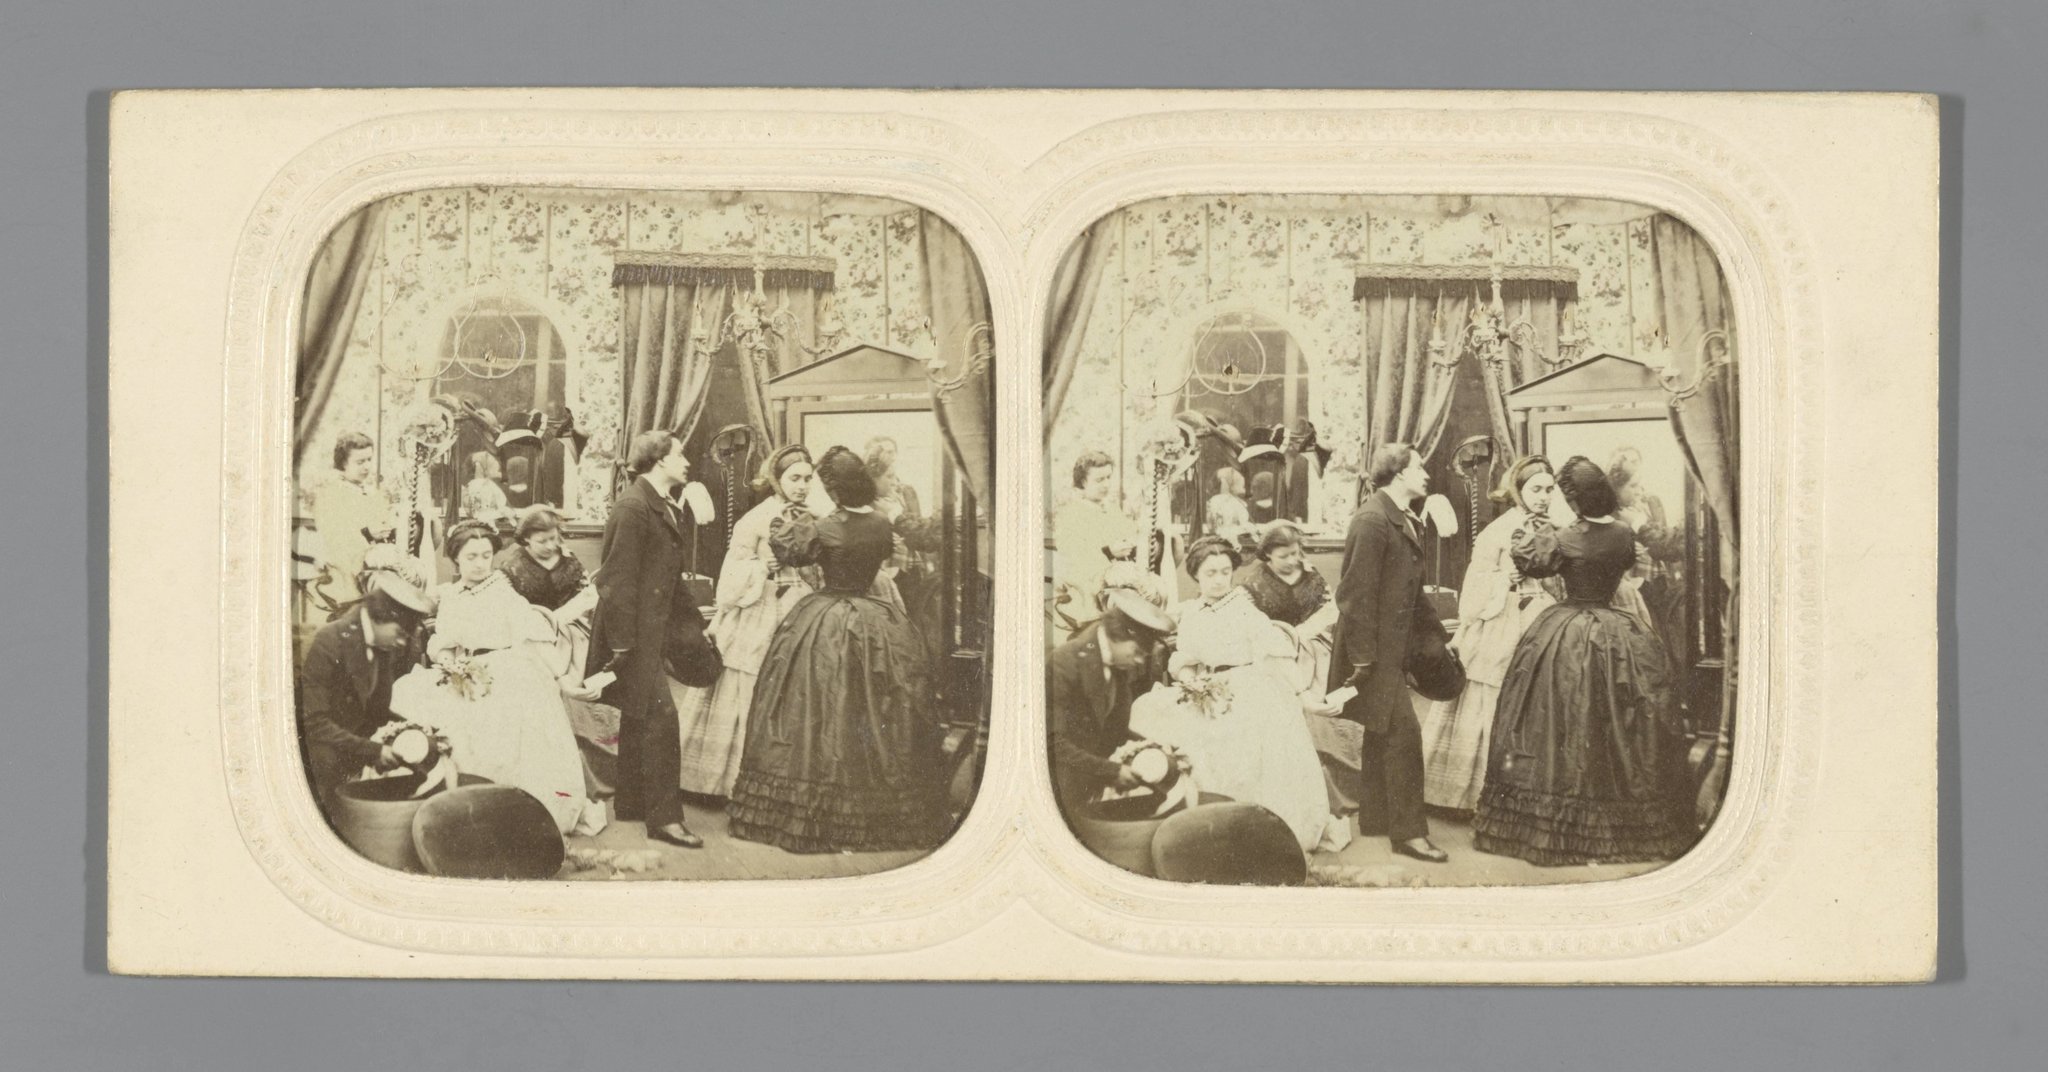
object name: tissue stereograph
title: Le 1er étage, la modiste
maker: Anonymous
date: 1860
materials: cardboard, paper, photographic support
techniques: albumen print, cutting, hand coloring, perforating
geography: paris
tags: head-gear: hat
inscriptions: number: ‘No 6’, number: ‘132’